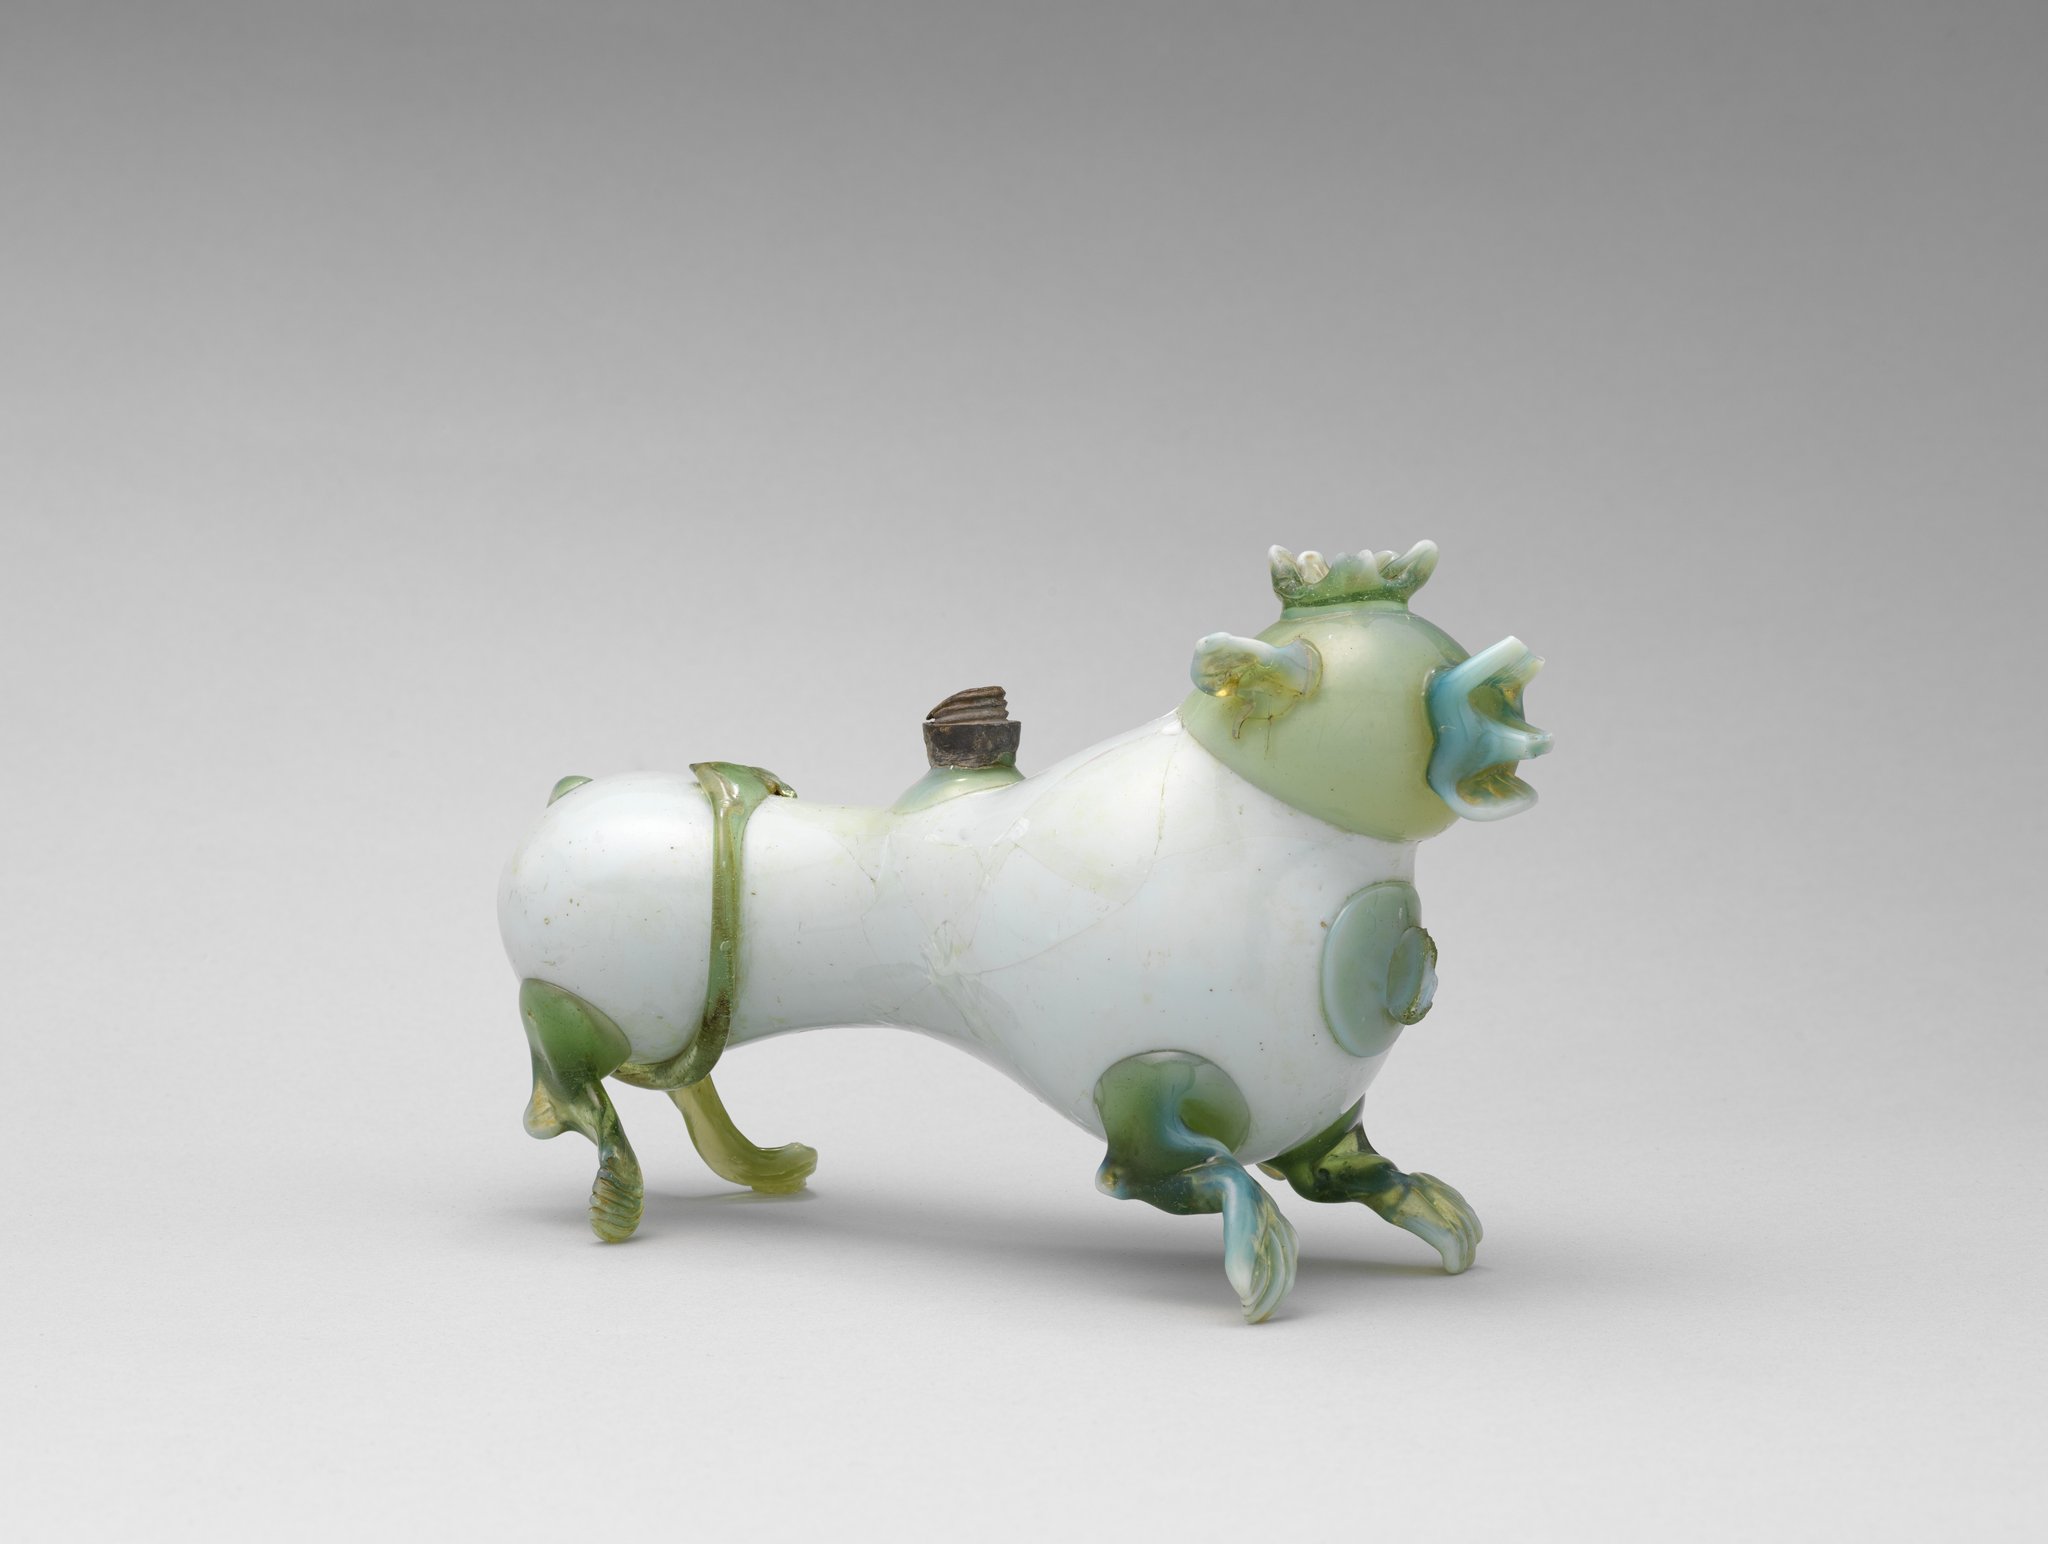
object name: bottle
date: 1601-1800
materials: glass, pewter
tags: animals